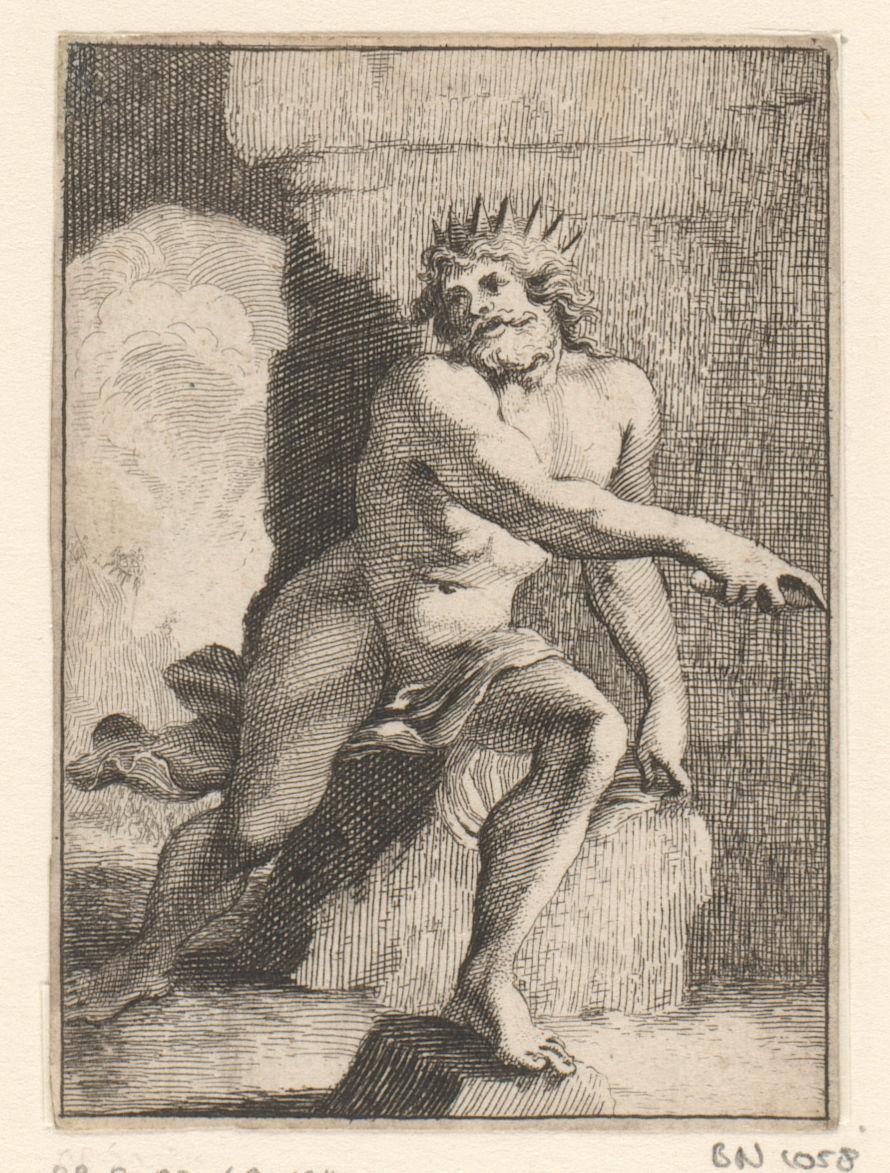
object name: print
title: Wijzende Pluto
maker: Anonymous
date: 1647-1714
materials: paper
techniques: engraving, etching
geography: france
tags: (story of) pluto (hades), dis pater, orcus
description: Deze prent is een anonieme kopie naar de originele prent van Sébastien Leclerc.